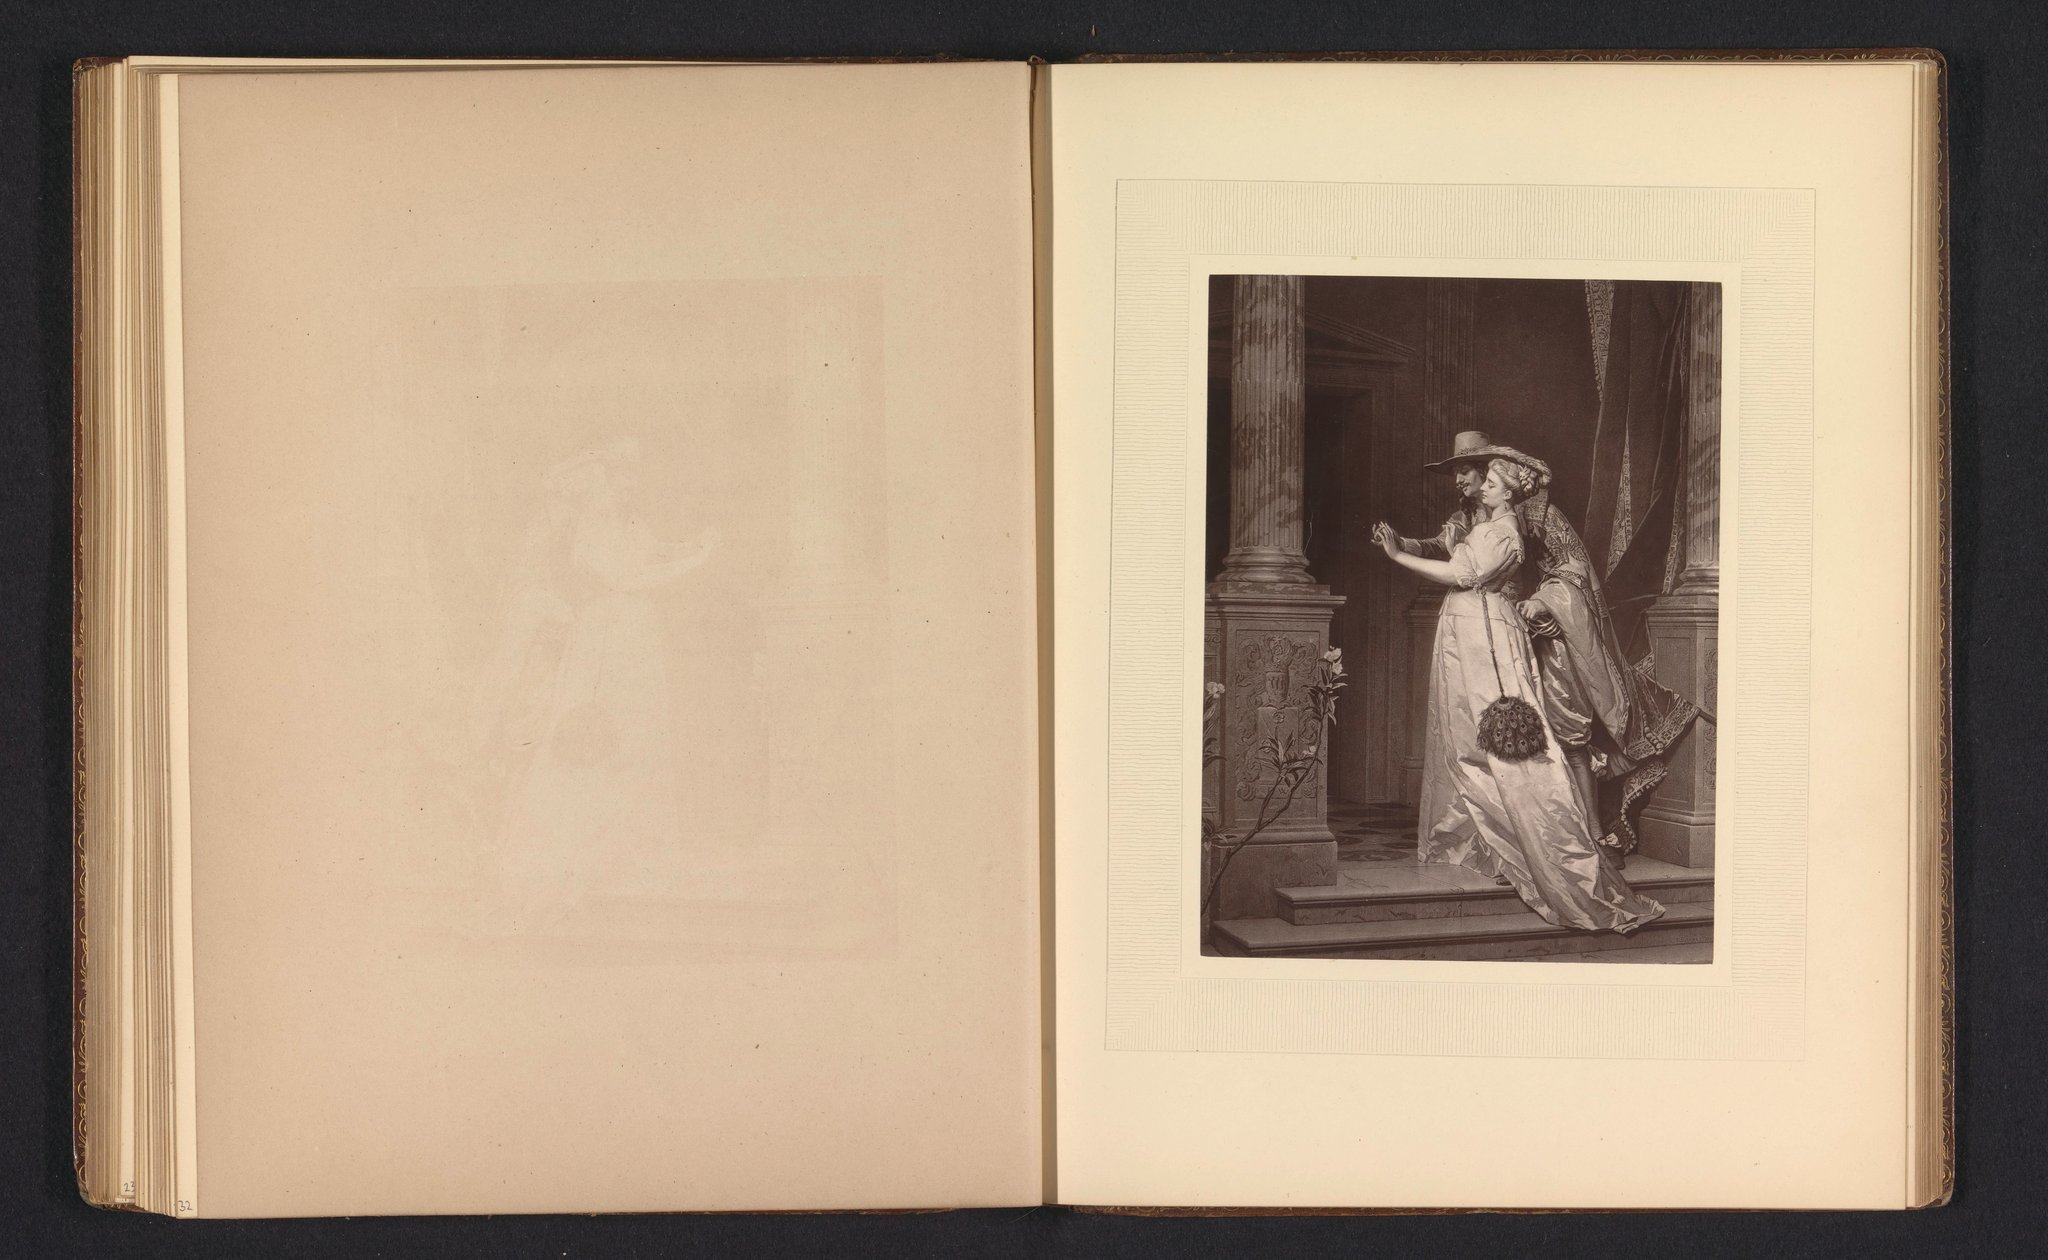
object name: photomechanical print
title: Fotoreproductie van een prent naar een schilderij van een man en een vrouw die een ring omdoet door Florent Joseph Marie Willems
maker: Anonymous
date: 1864-1874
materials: paper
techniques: woodburytype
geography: london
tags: ring, picture, painting